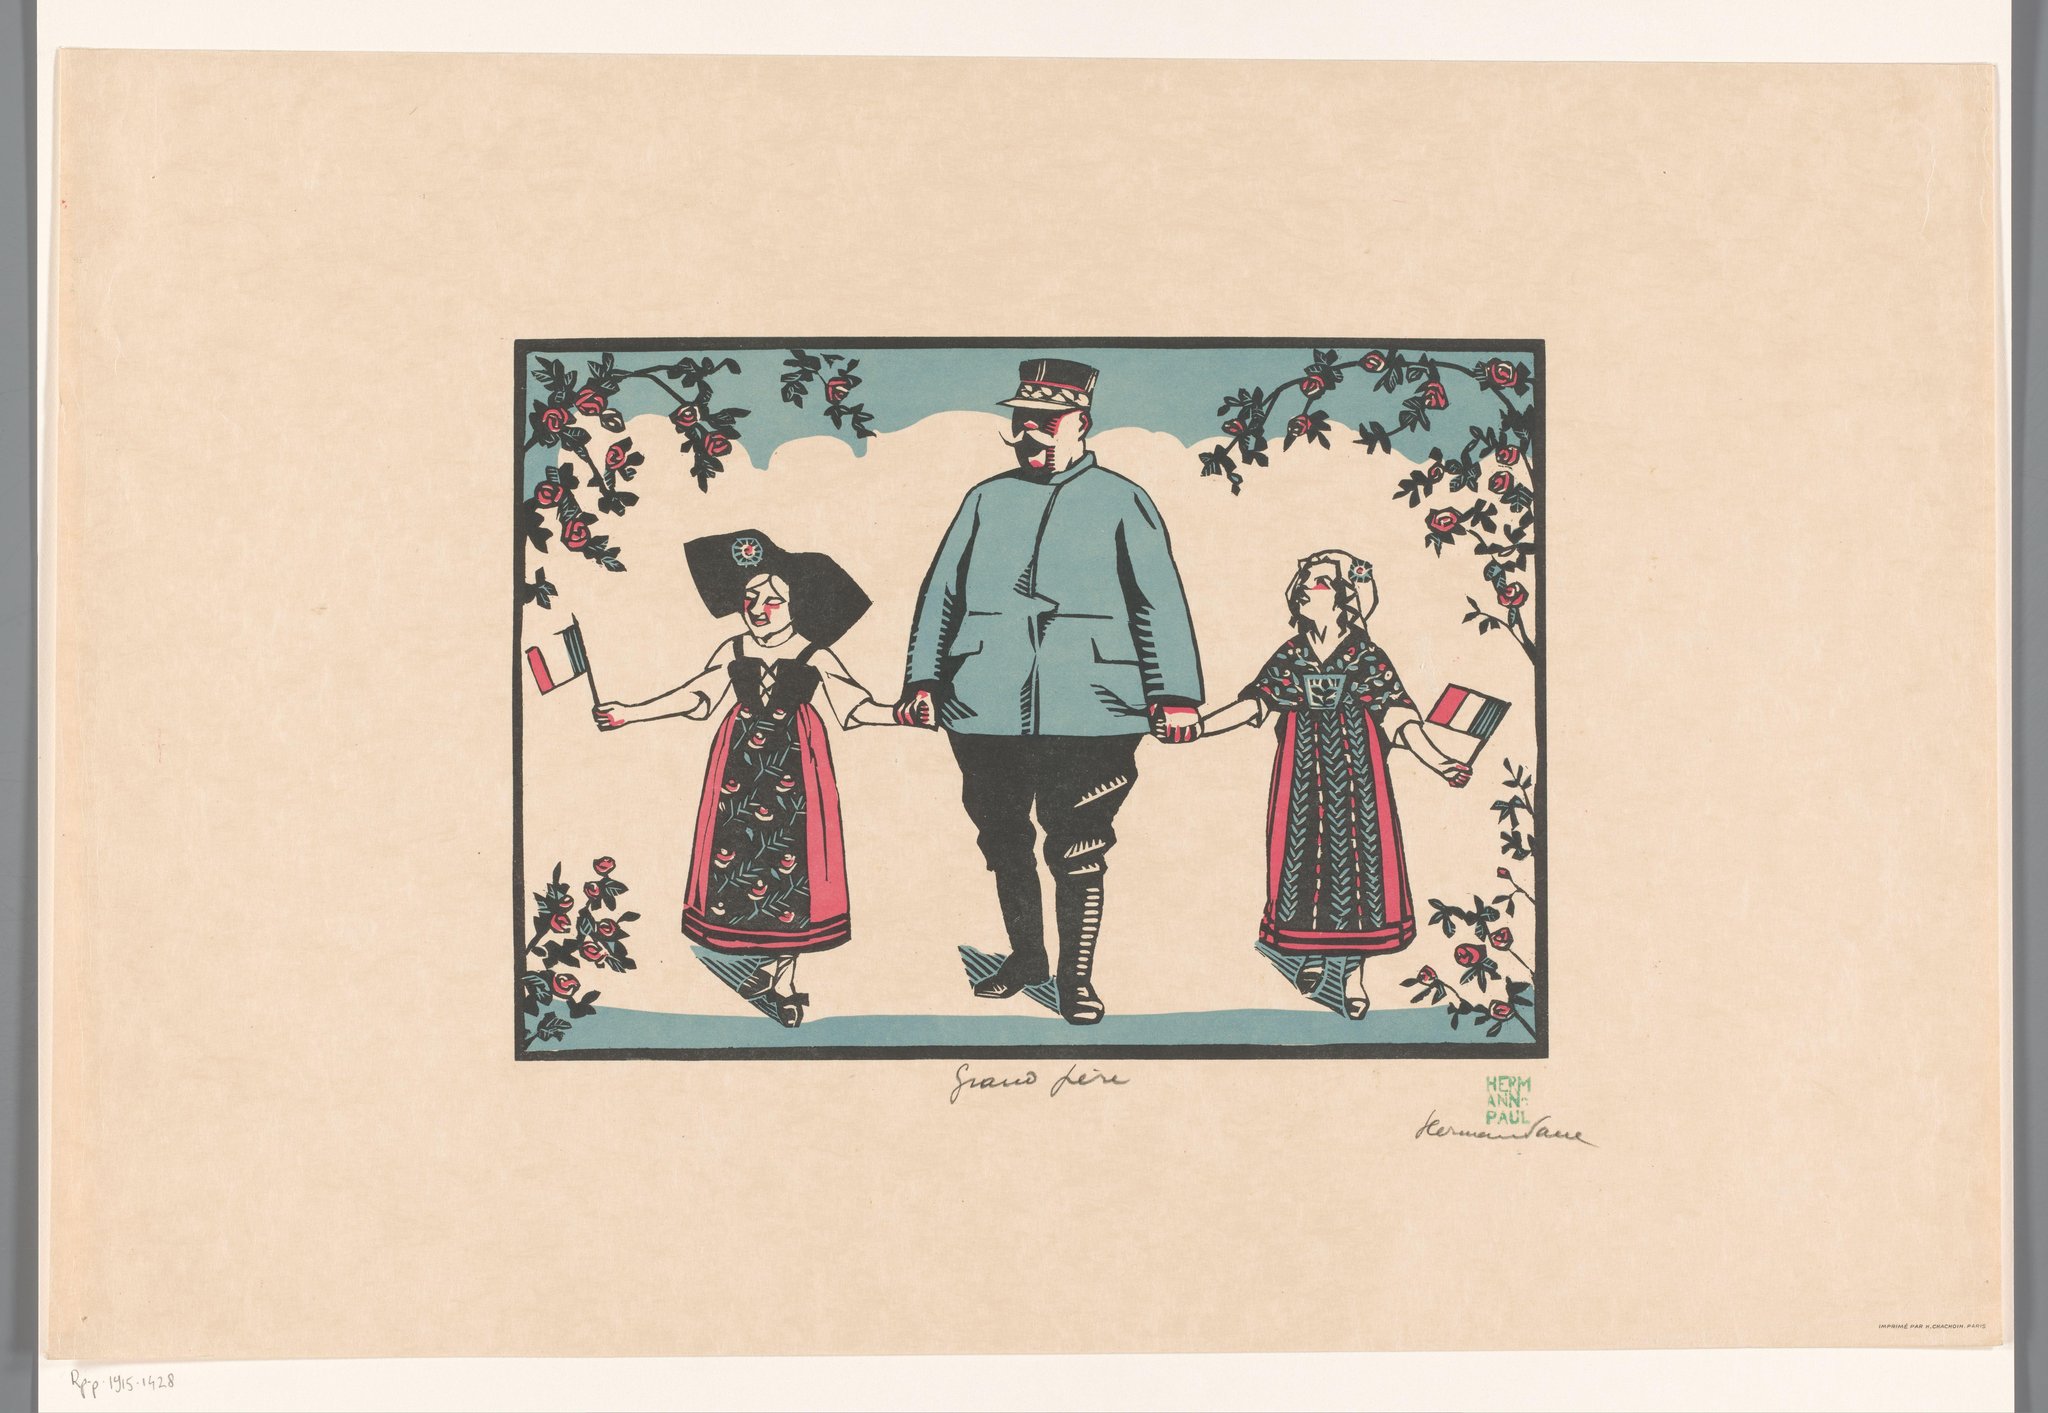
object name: print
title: Grand père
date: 1874-1915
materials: paper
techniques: woodcut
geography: paris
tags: grandparent(s) with grandchild(ren) (family group)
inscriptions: workshop stamp: ‘Hermann: Paul’, collector's mark: Lugt 2233